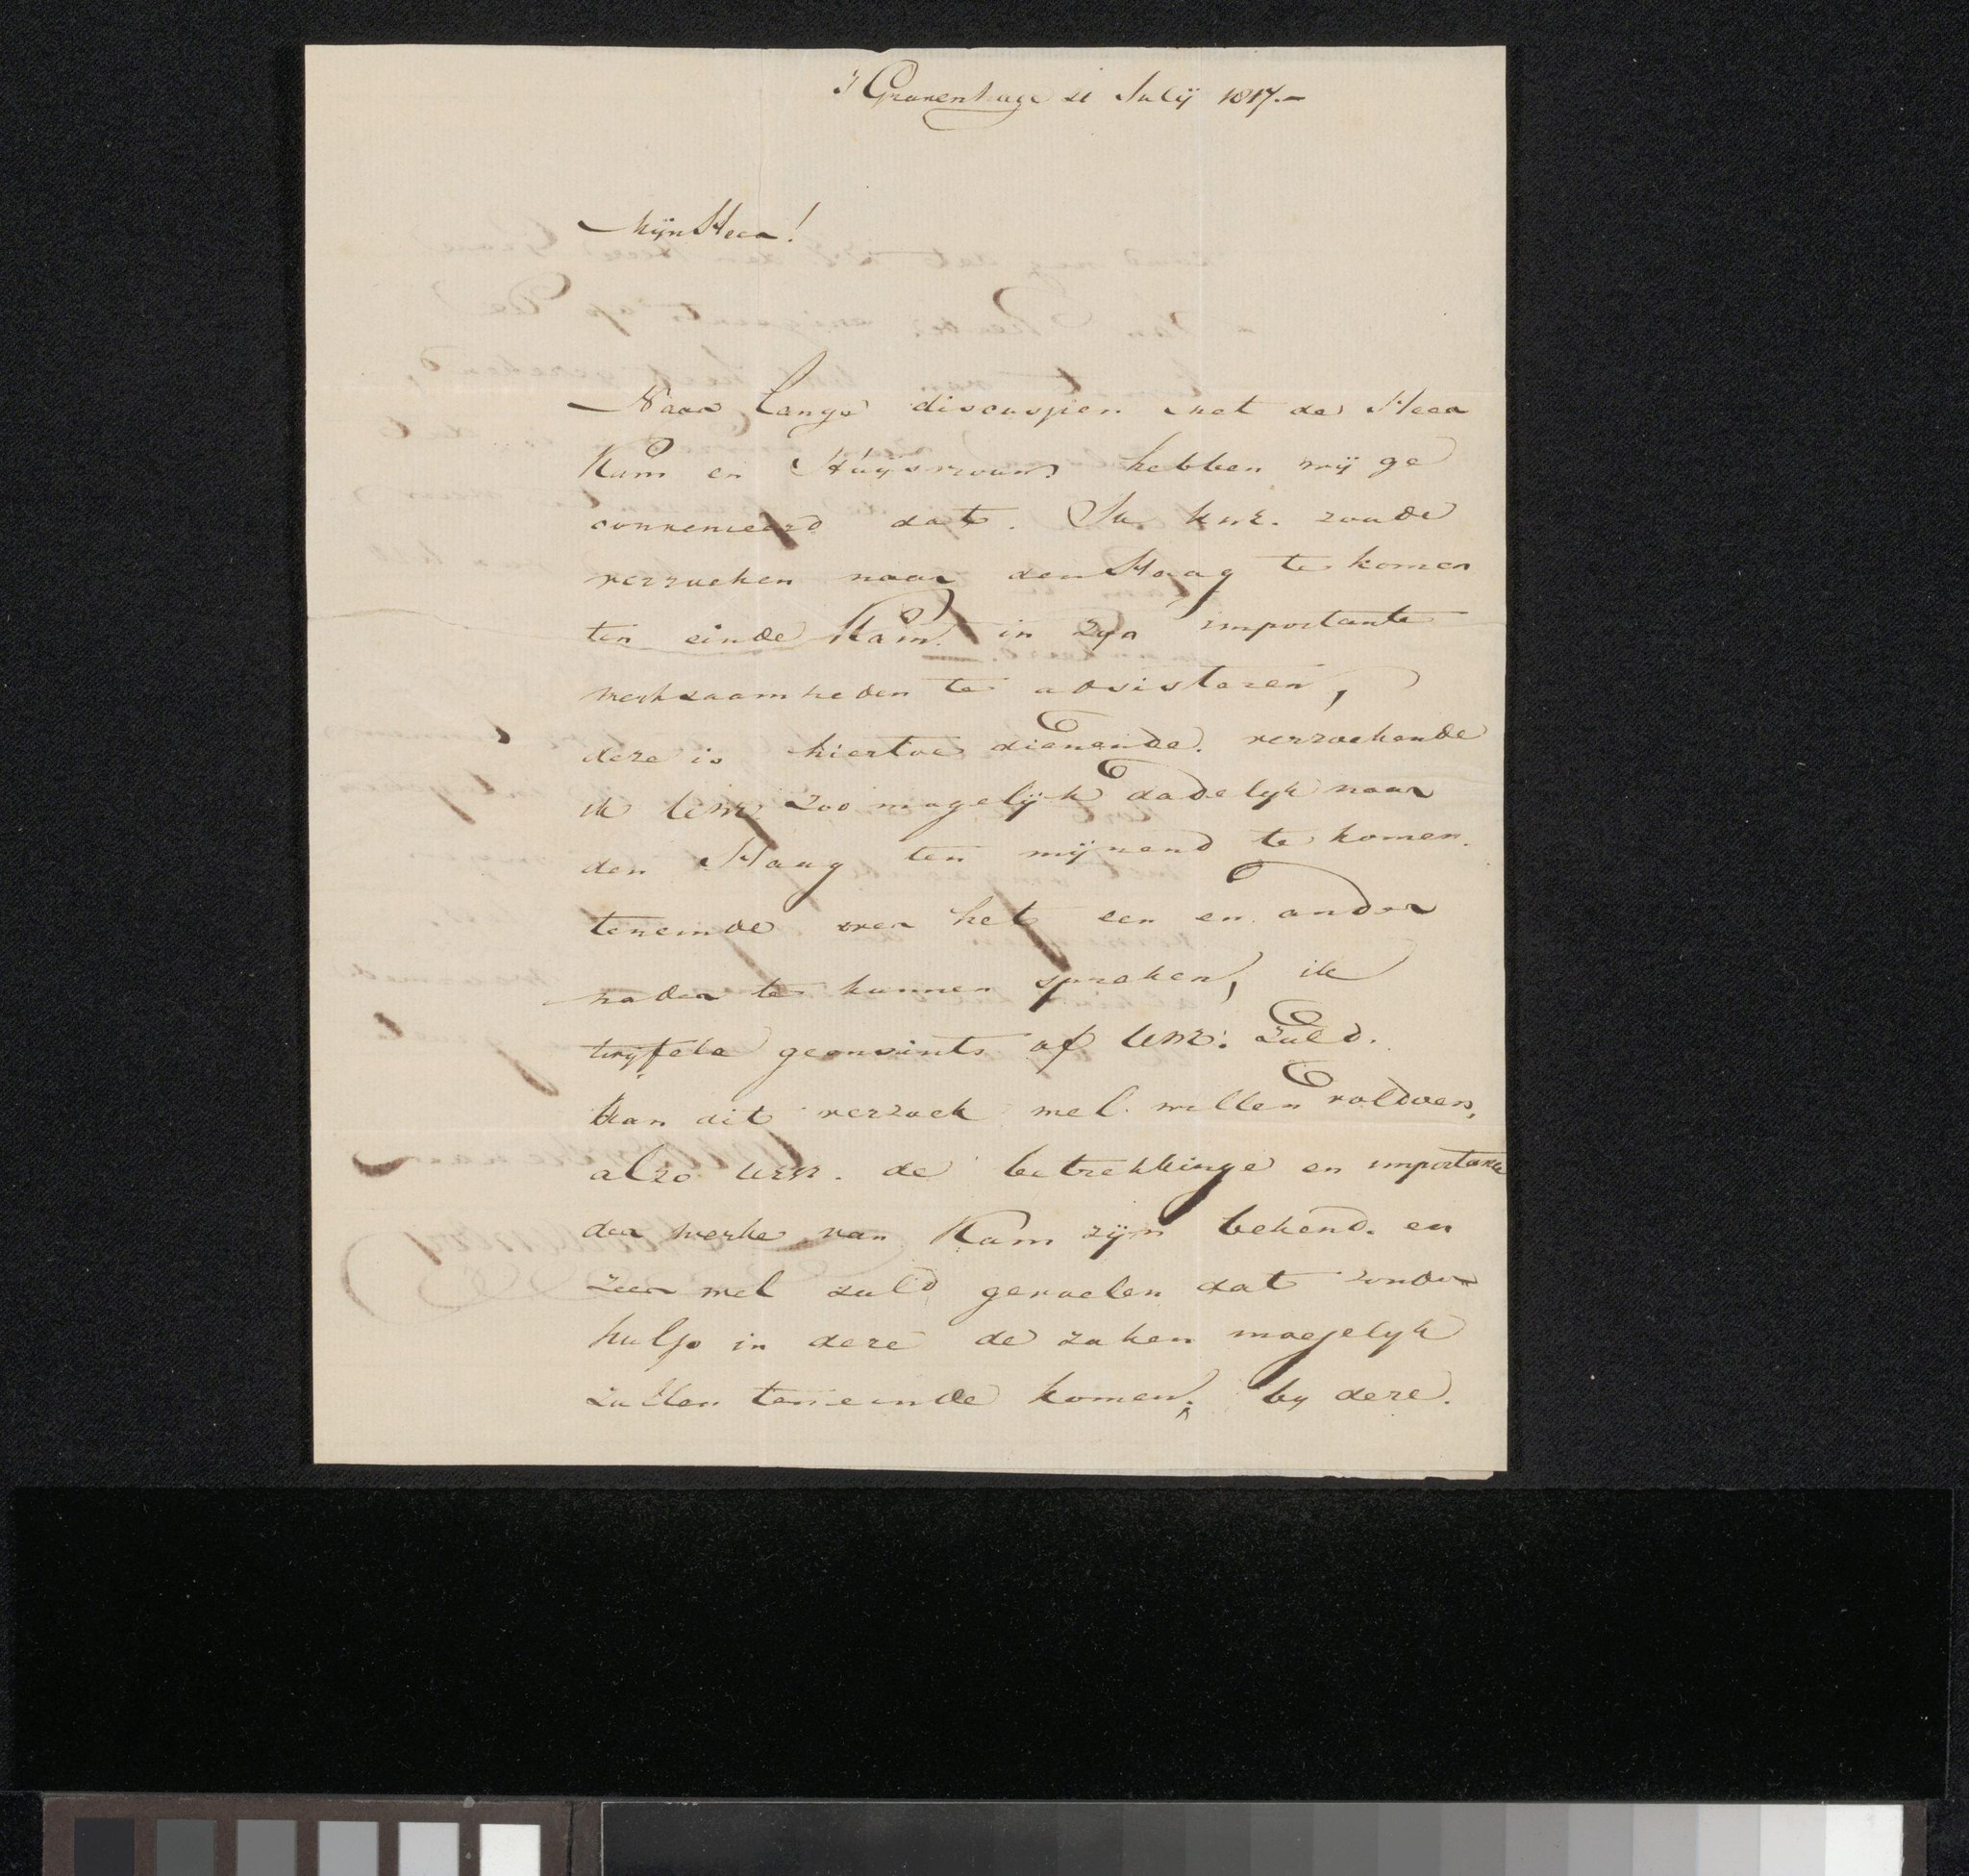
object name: letter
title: Brief aan onbekend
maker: adriaan noordendorp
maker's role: architect, landmeter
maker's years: 1780-1833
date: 1817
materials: ink, paper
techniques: pen, writing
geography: the hague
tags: the hague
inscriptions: seal, watermark